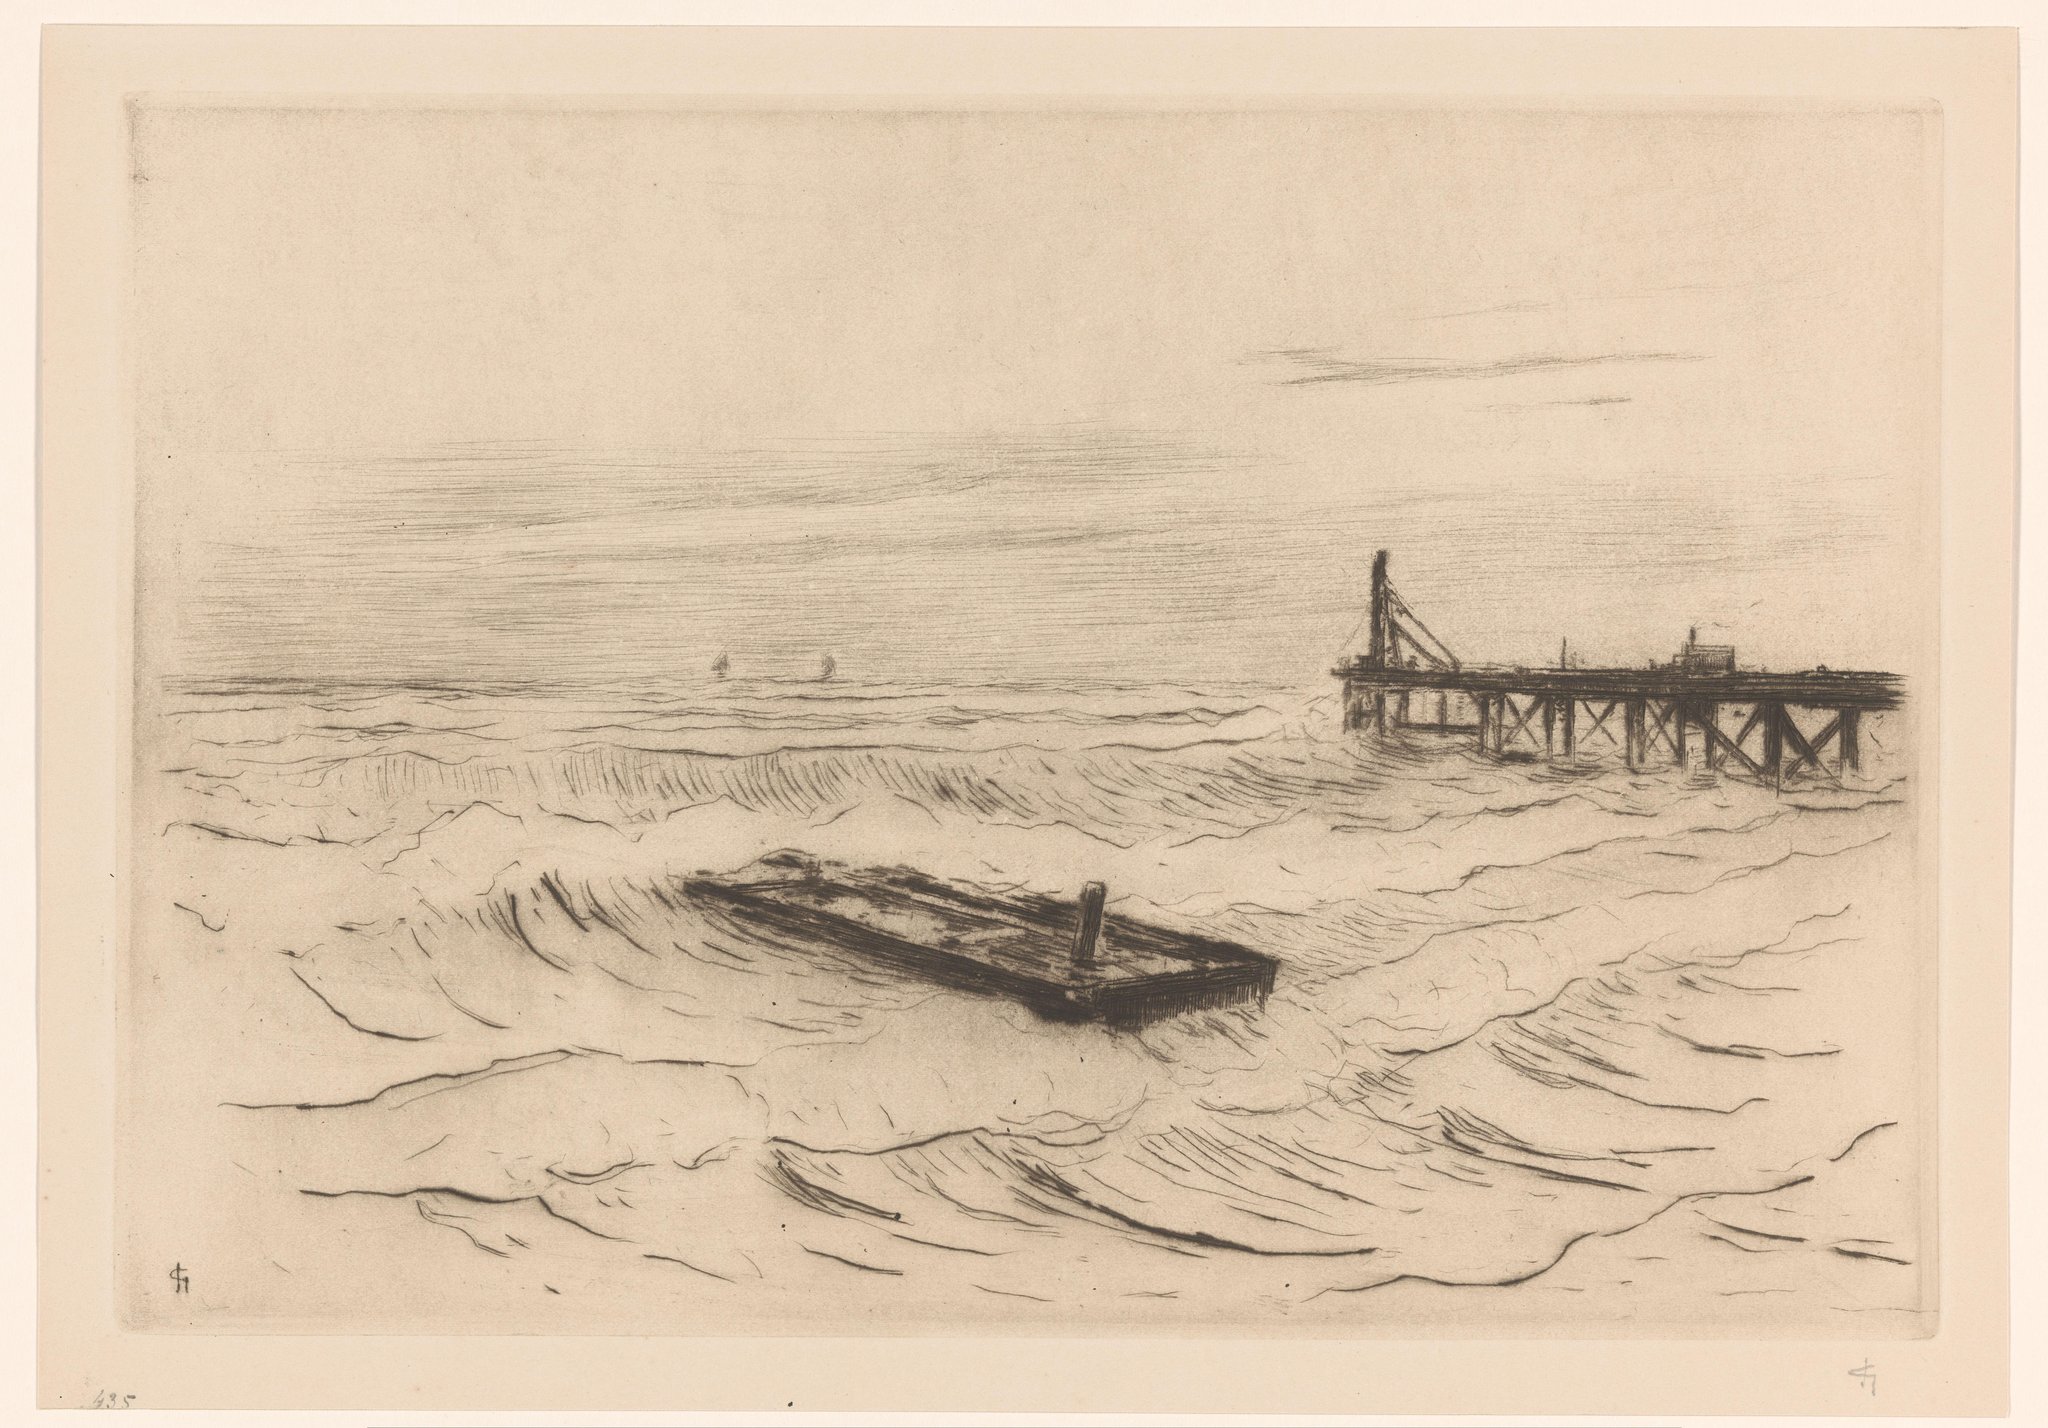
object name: print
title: Pier van Scheveningen in aanbouw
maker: carel nicolaas storm van s-gravesande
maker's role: draughtsman, print maker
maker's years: 1841-1924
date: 1851-1902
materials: paper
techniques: drypoint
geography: netherlands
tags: sea (seascape), pier, quay, wharf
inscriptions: collector's mark: Lugt 2228, number: ‘435’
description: Mogelijk vermeld in: Storm van 's-Gravesande, Charles. Catalogue des eaux-fortes et lithographies. New York: s.n., 1903, of in een onbekende latere uitgave van het manuscript. Vermoedelijk vermeld als catalogusnummer 435.